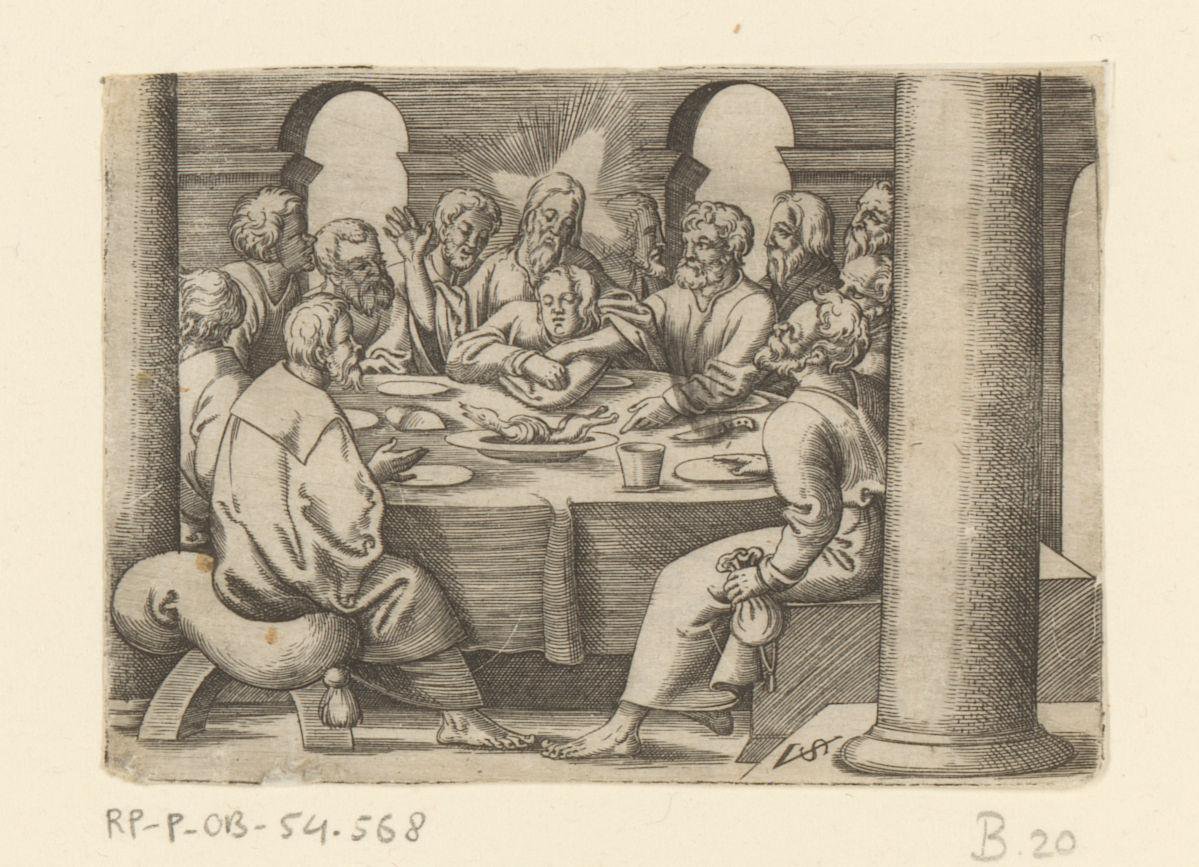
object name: print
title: Laatste Avondmaal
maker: virgilius solis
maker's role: draughtsman, print maker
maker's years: 1514-1562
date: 1524-1562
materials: paper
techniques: engraving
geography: nuremberg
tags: last supper (in general) (matthew 26:21-35; mark 14:18-31; luke 22:3, 22:15-23; john 13:21-38)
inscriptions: collector's mark: Lugt 2228, number: ‘84’